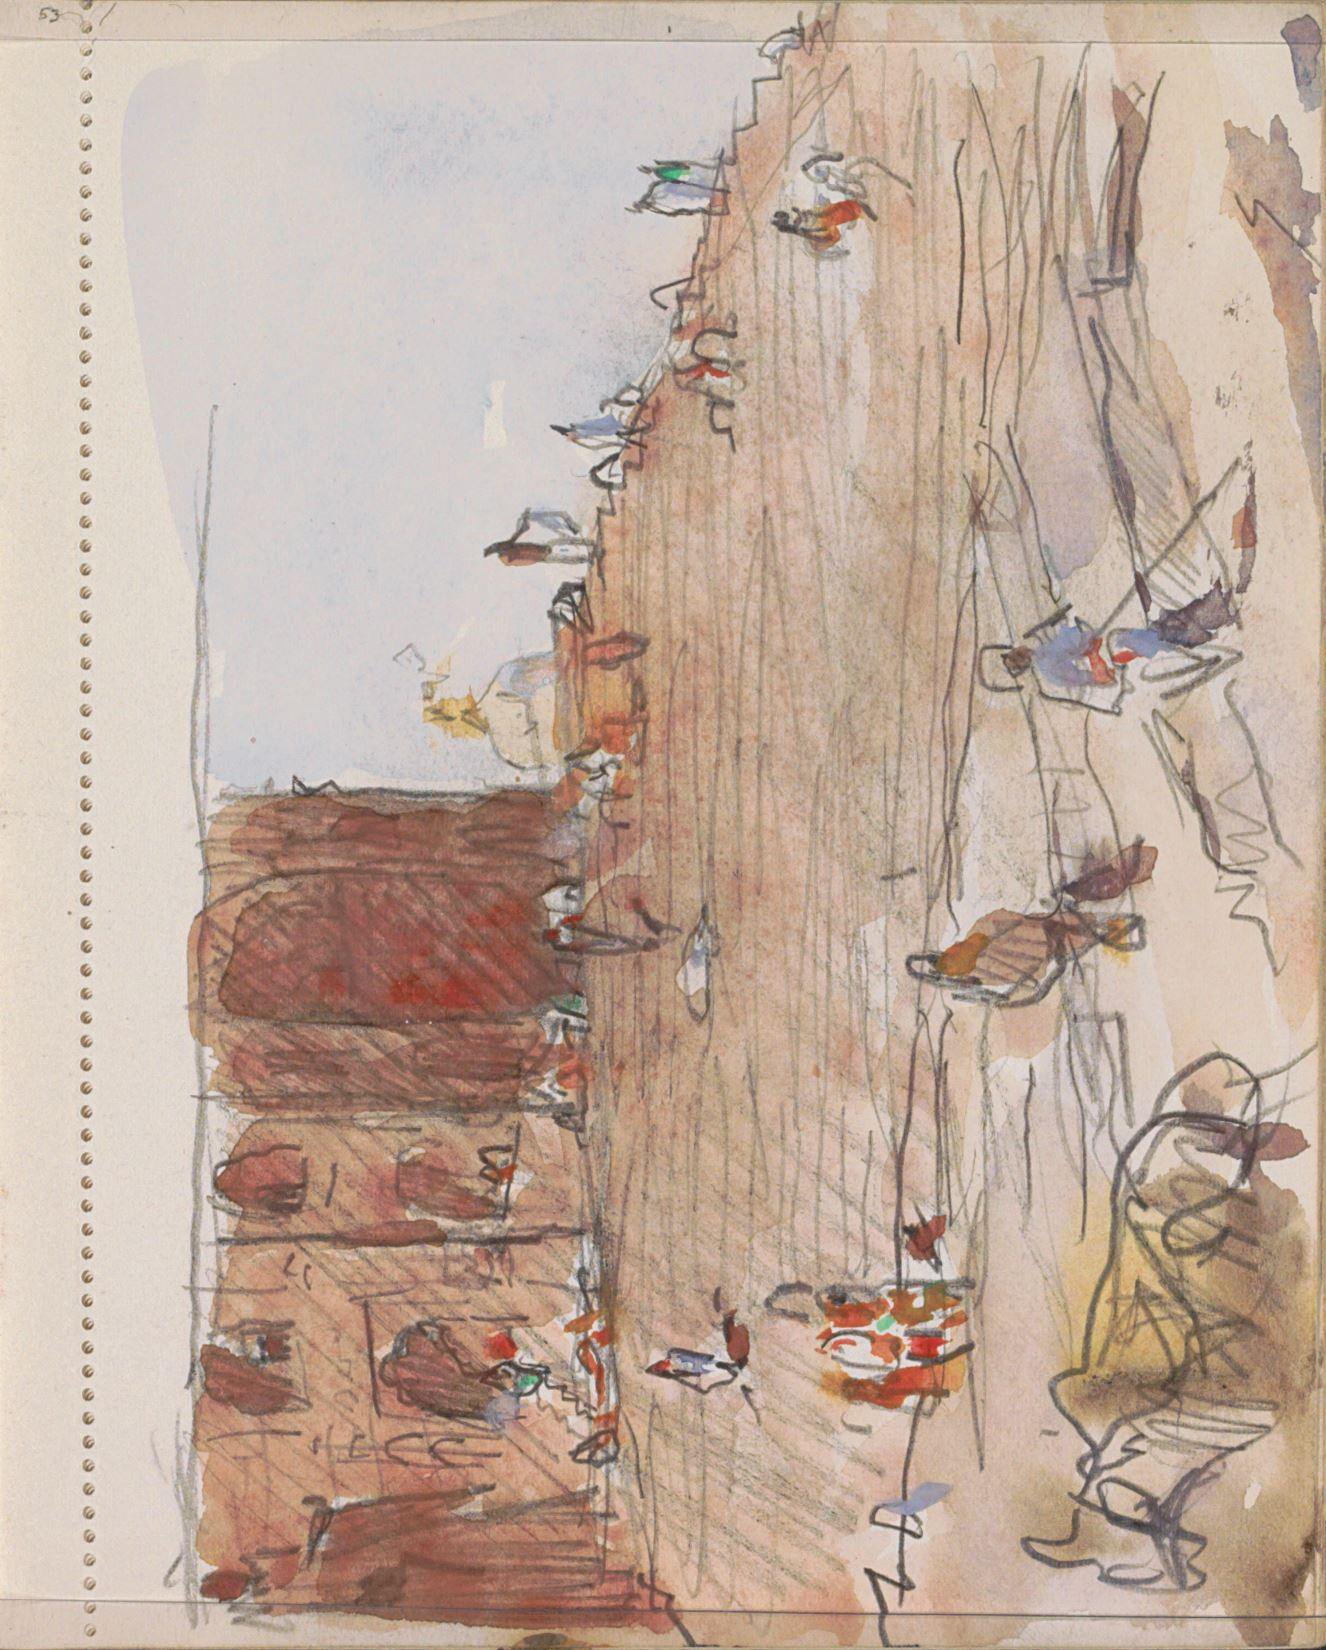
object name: sketchbook leaf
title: Figuren op de trappen voor een gebouw, mogelijk een tempel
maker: marius bauer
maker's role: draughtsman, print maker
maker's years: 1867-1932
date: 1924-1925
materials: paper, pencil, watercolor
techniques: brush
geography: india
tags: sitting figure, flight of steps, ox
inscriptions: kleurnotitie, handgeschreven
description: Op de voorgrond een os. Pagina 53 uit een schetsboek met 75 bladen.